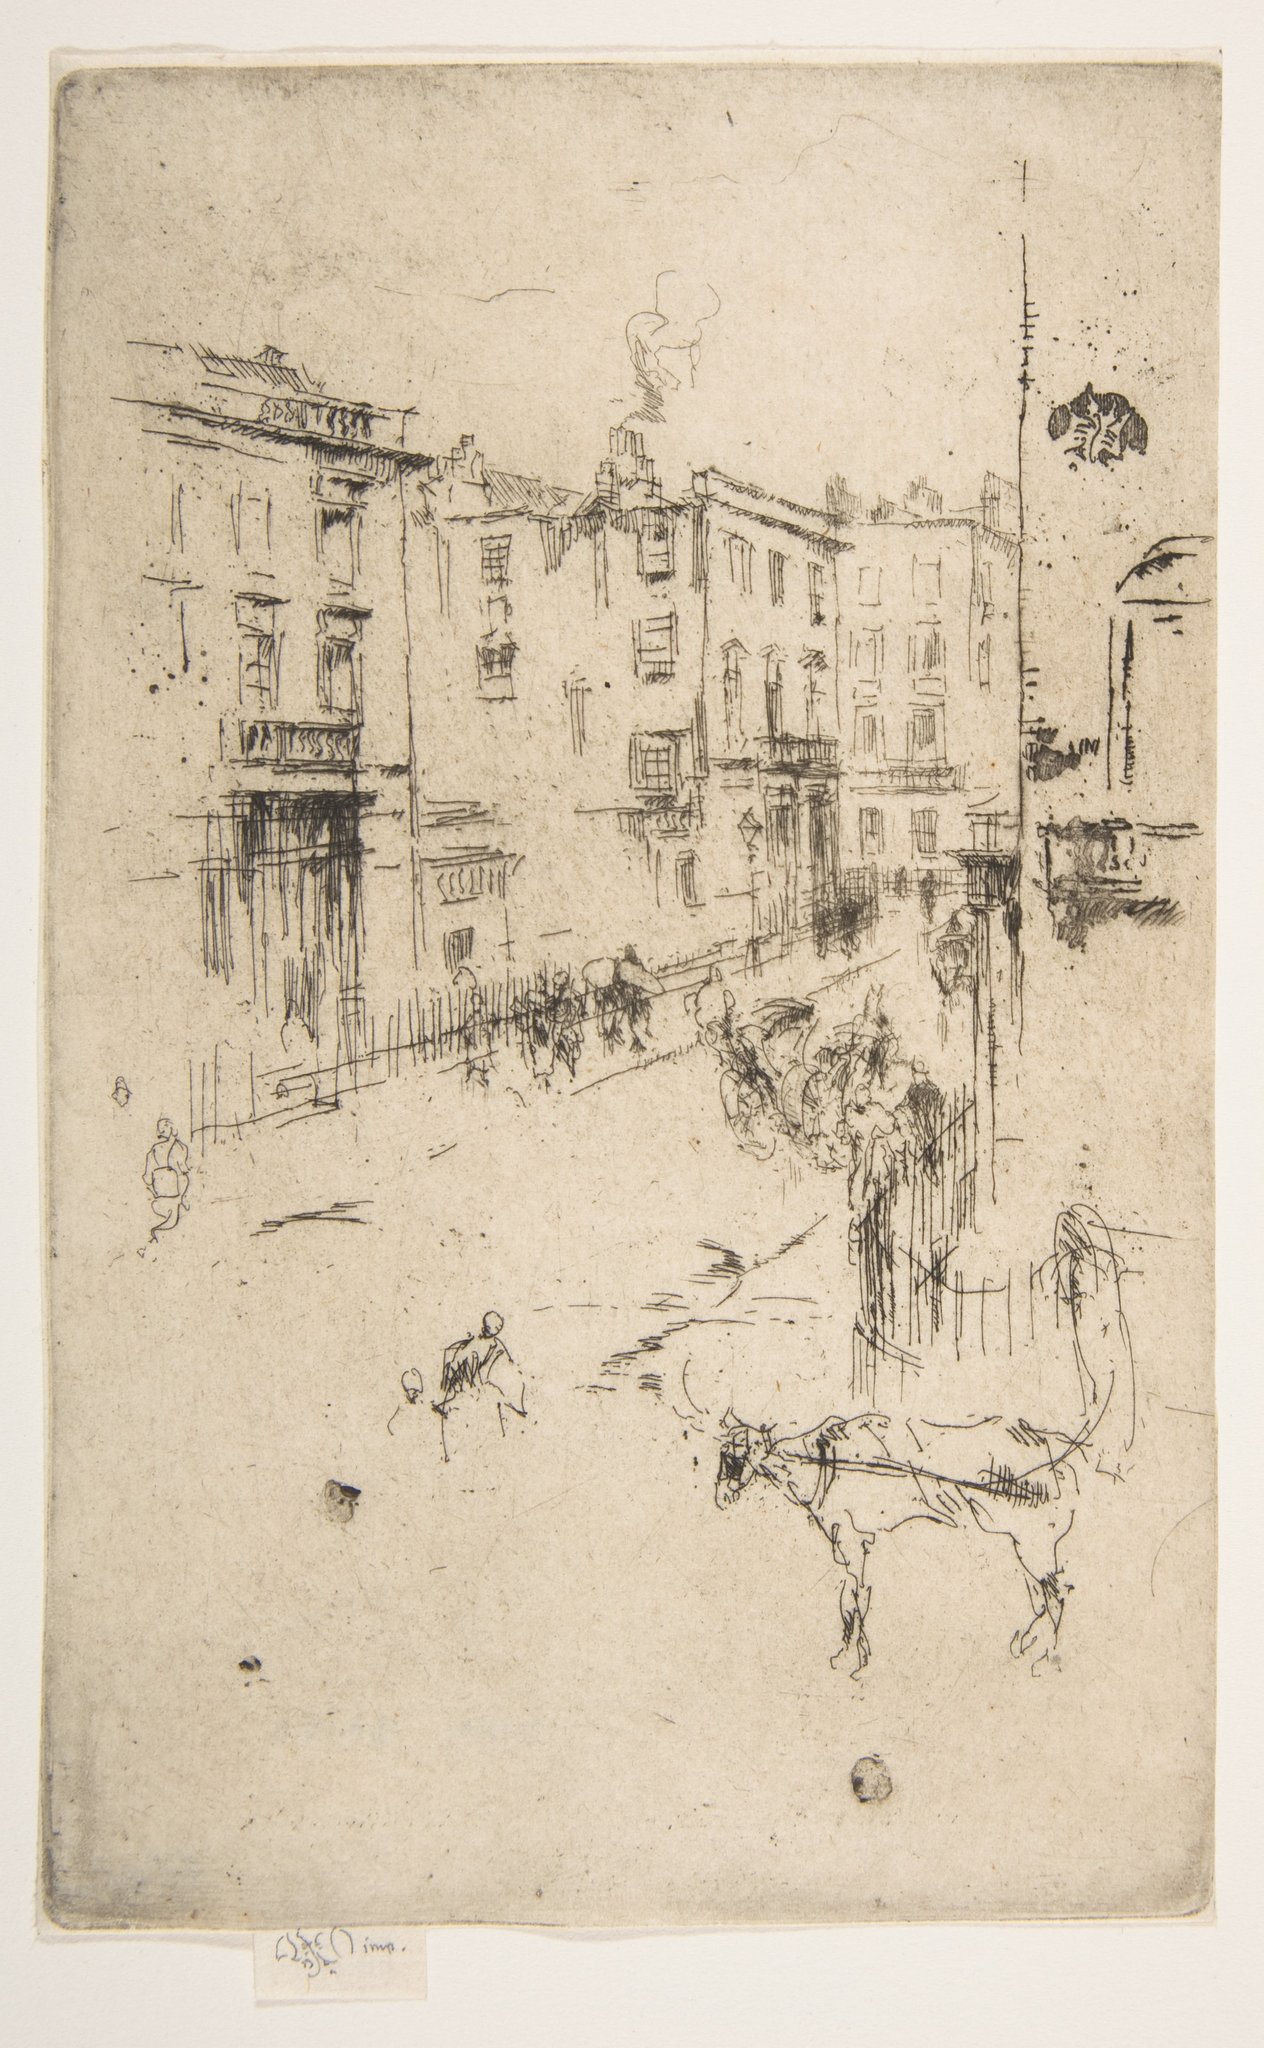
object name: print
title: Alderney Street, from "Gazette des Beaux-Arts," 1881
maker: james mcneill whistler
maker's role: artist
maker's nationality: american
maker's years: 1834-1903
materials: ink, paper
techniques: etching, printing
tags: animals,buildings,streets,london